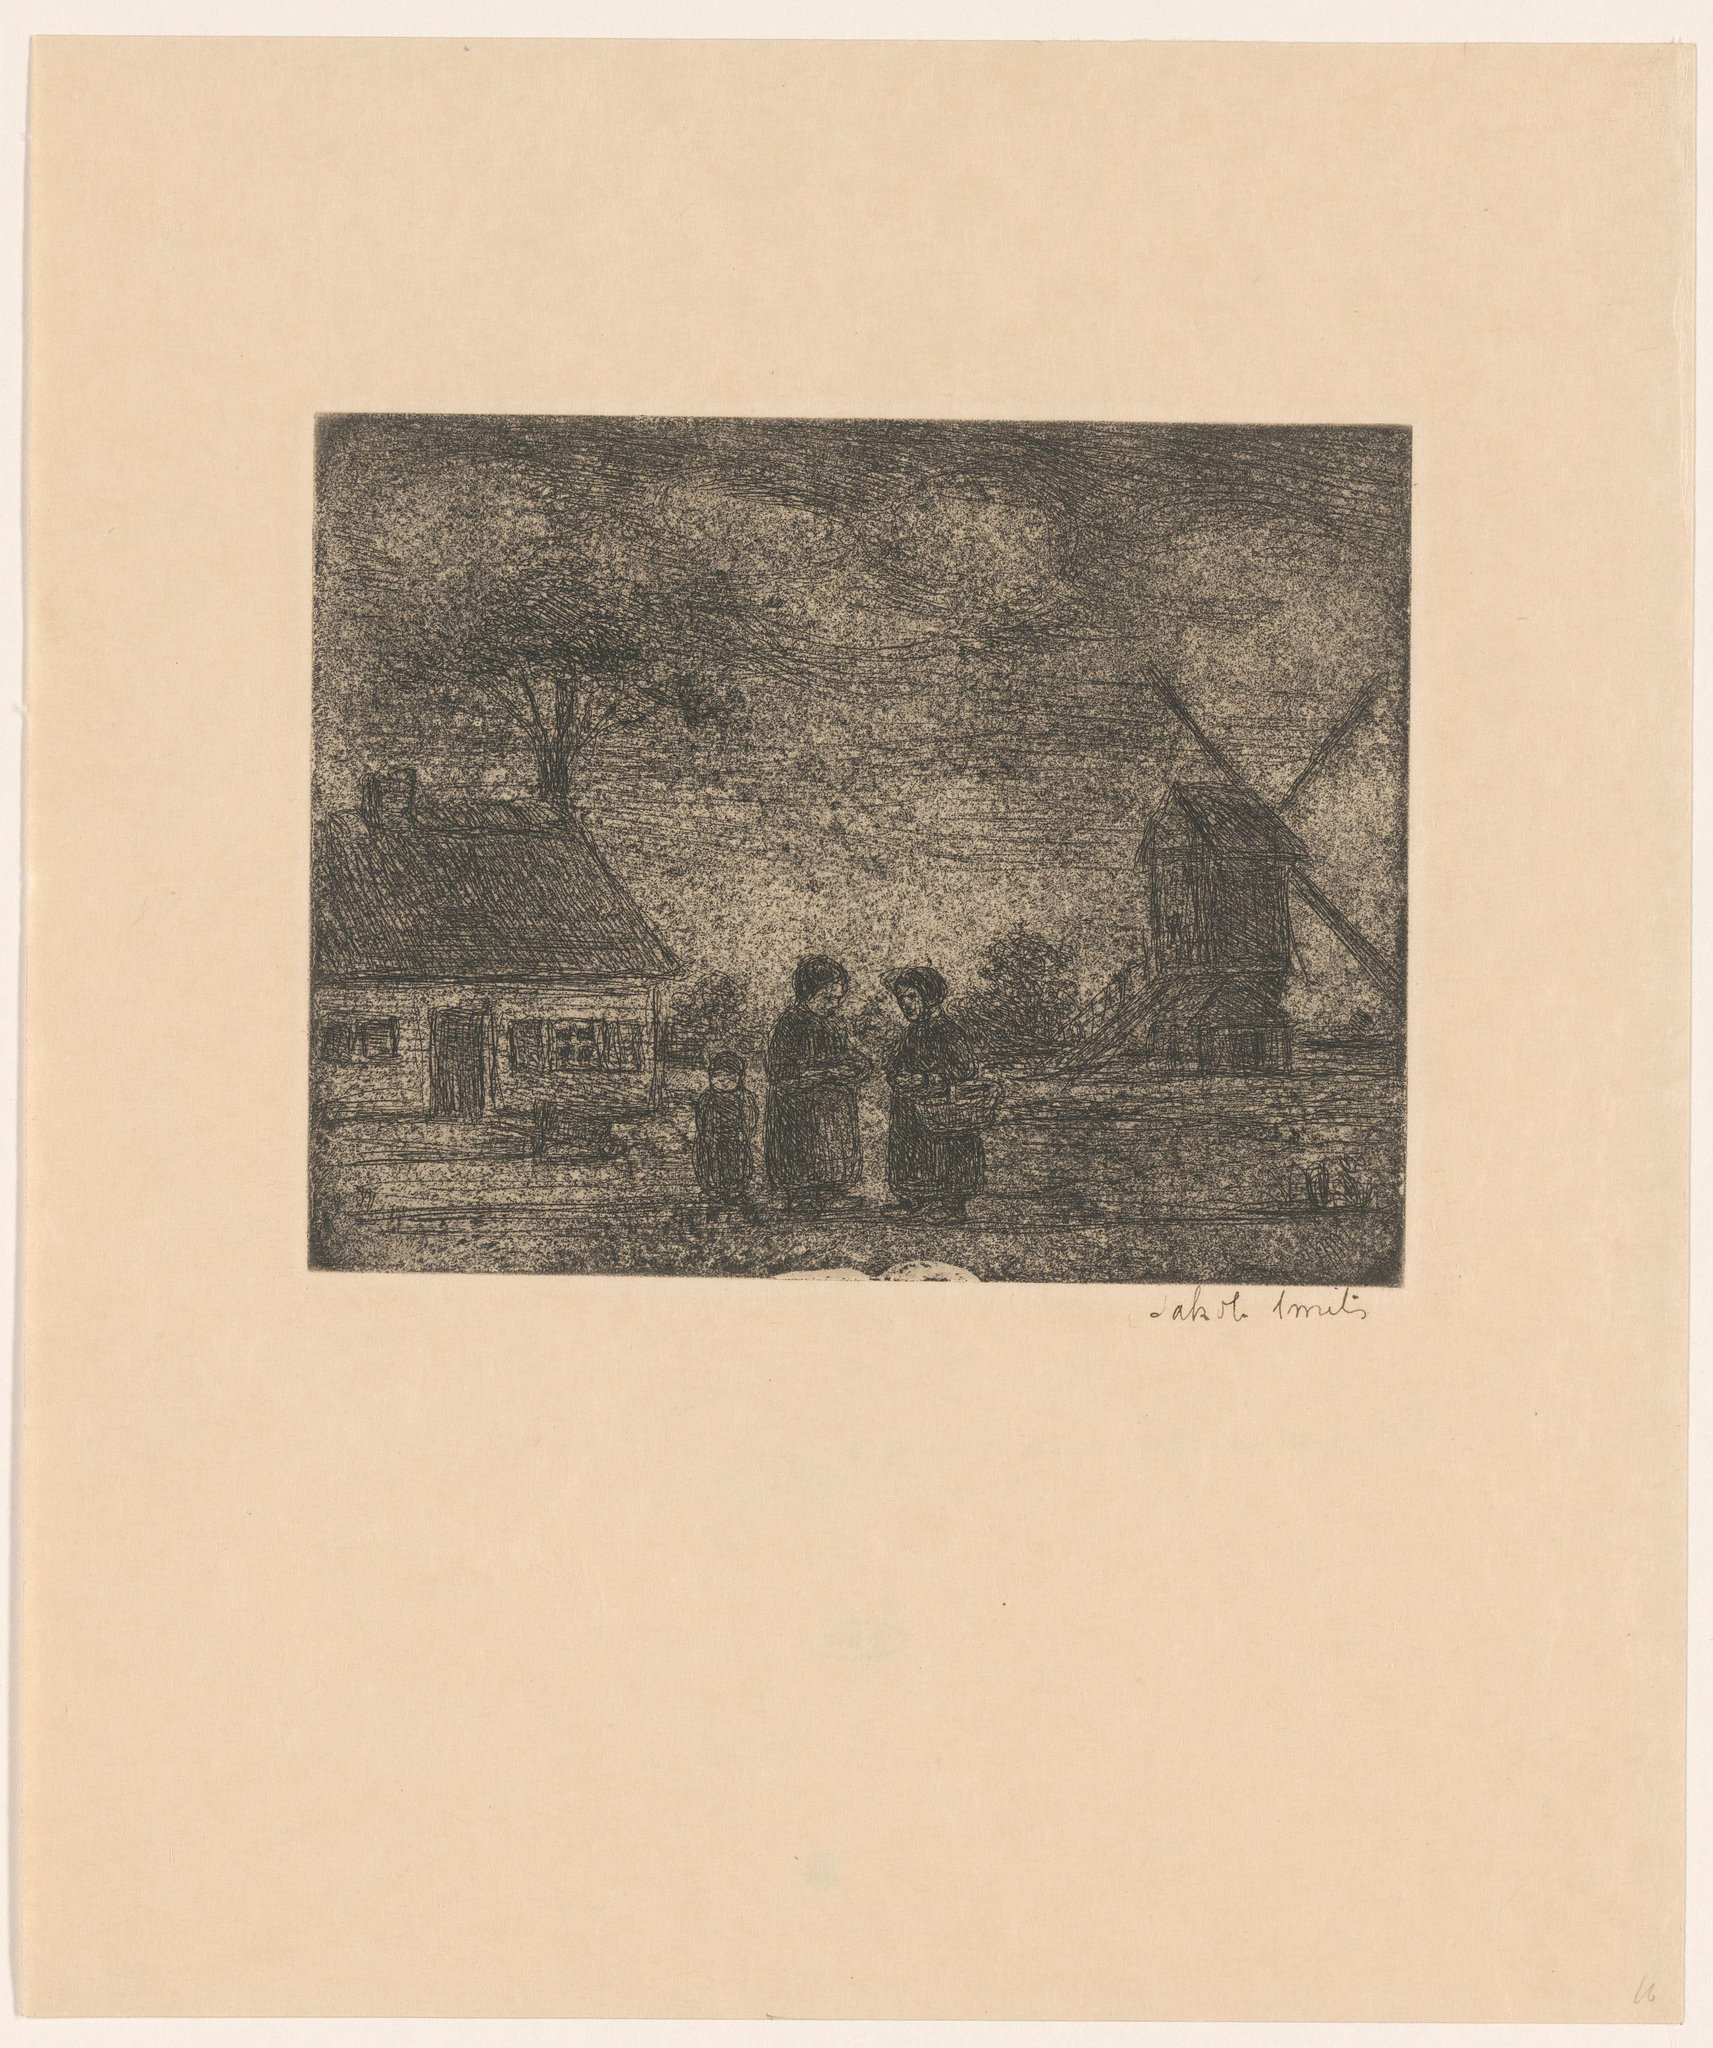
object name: print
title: Bij het vallen van den avond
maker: jakob smits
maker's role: draughtsman, print maker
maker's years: 1855-1928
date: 1901-1925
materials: paper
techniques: etching, intaglio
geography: netherlands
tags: dusk, evening twilight, windmill in landscape (+ city(-scape) with figures, staffage)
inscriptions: collector's mark: Lugt 2760, collector's mark: Lugt 2228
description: Op de voorgrond staan twee vrouwen en een kind.